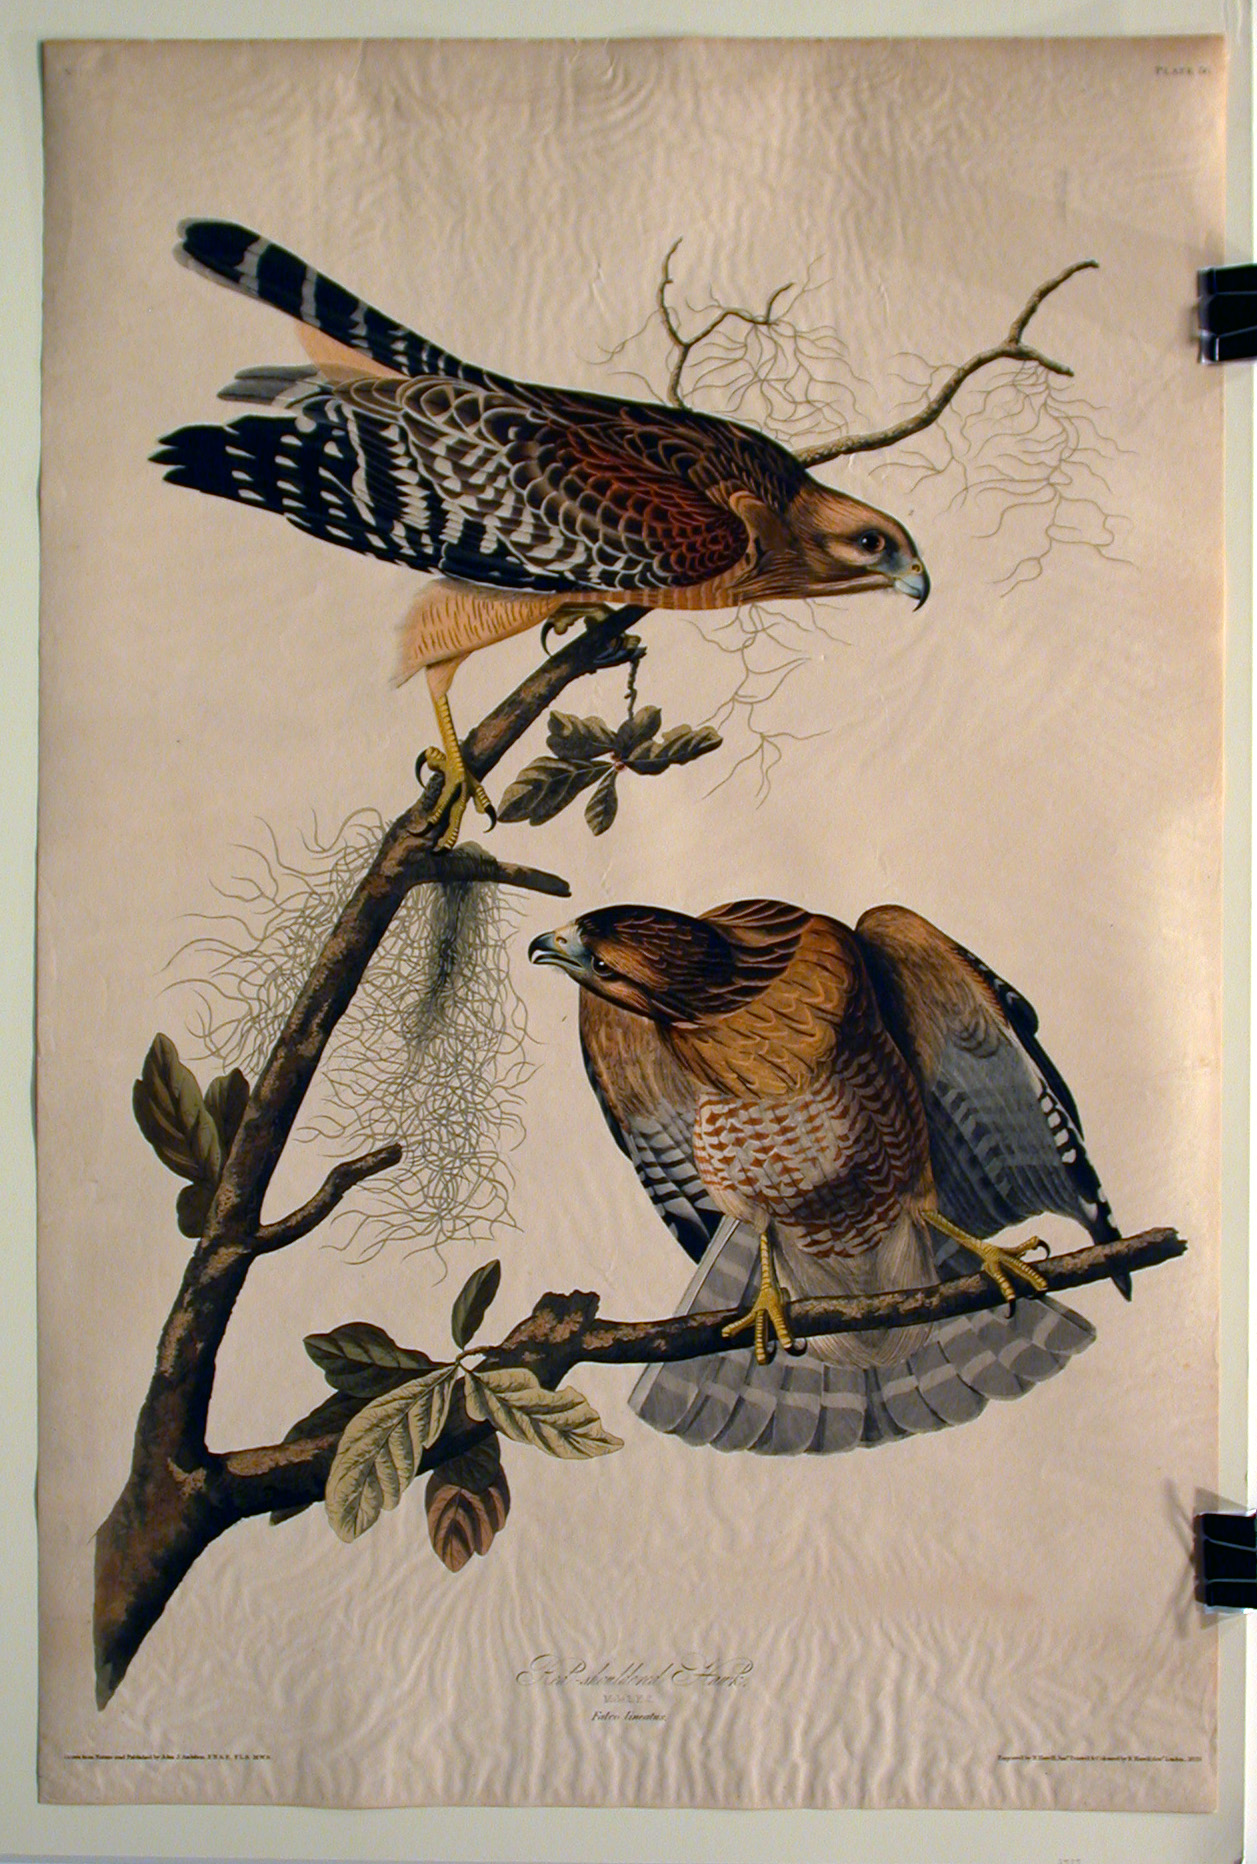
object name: print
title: Red Shouldered Hawk (No. 12)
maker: john james audubon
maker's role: artist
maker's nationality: american, born haiti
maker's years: 1785-1851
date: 1829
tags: hawks